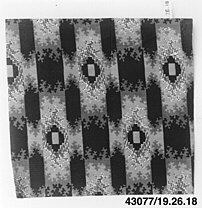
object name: sample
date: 1840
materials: cotton